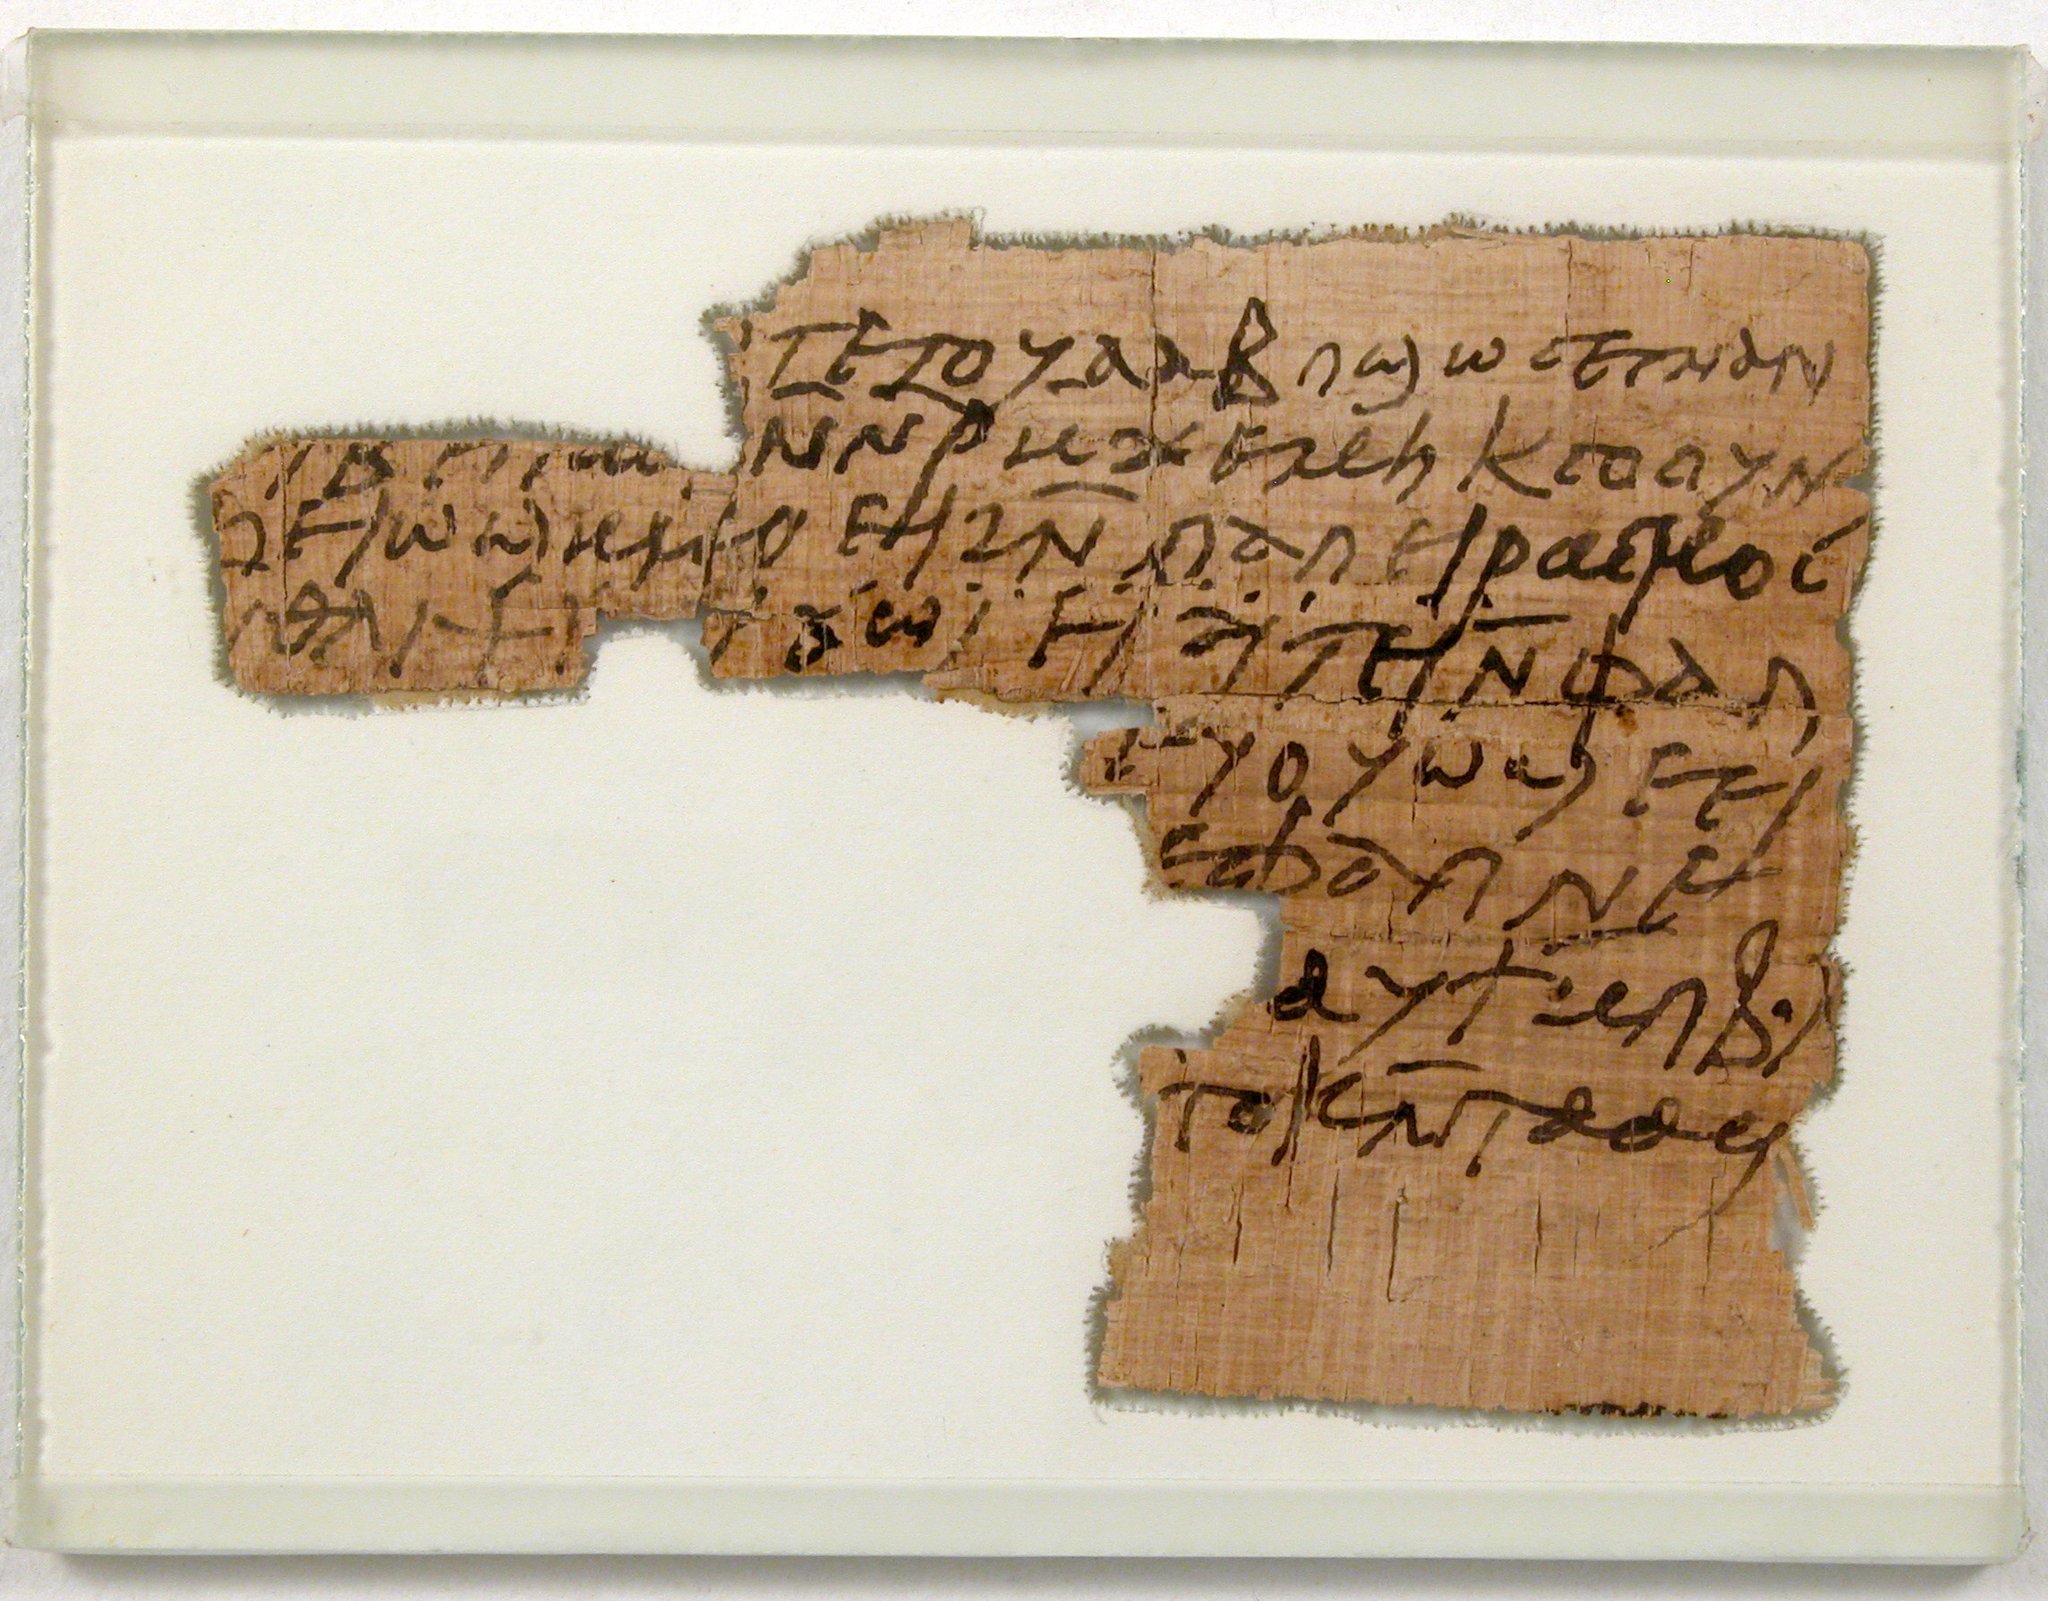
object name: fragment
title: Papyrus Fragment of a Letter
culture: coptic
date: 601-700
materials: ink, papyrus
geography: egypt